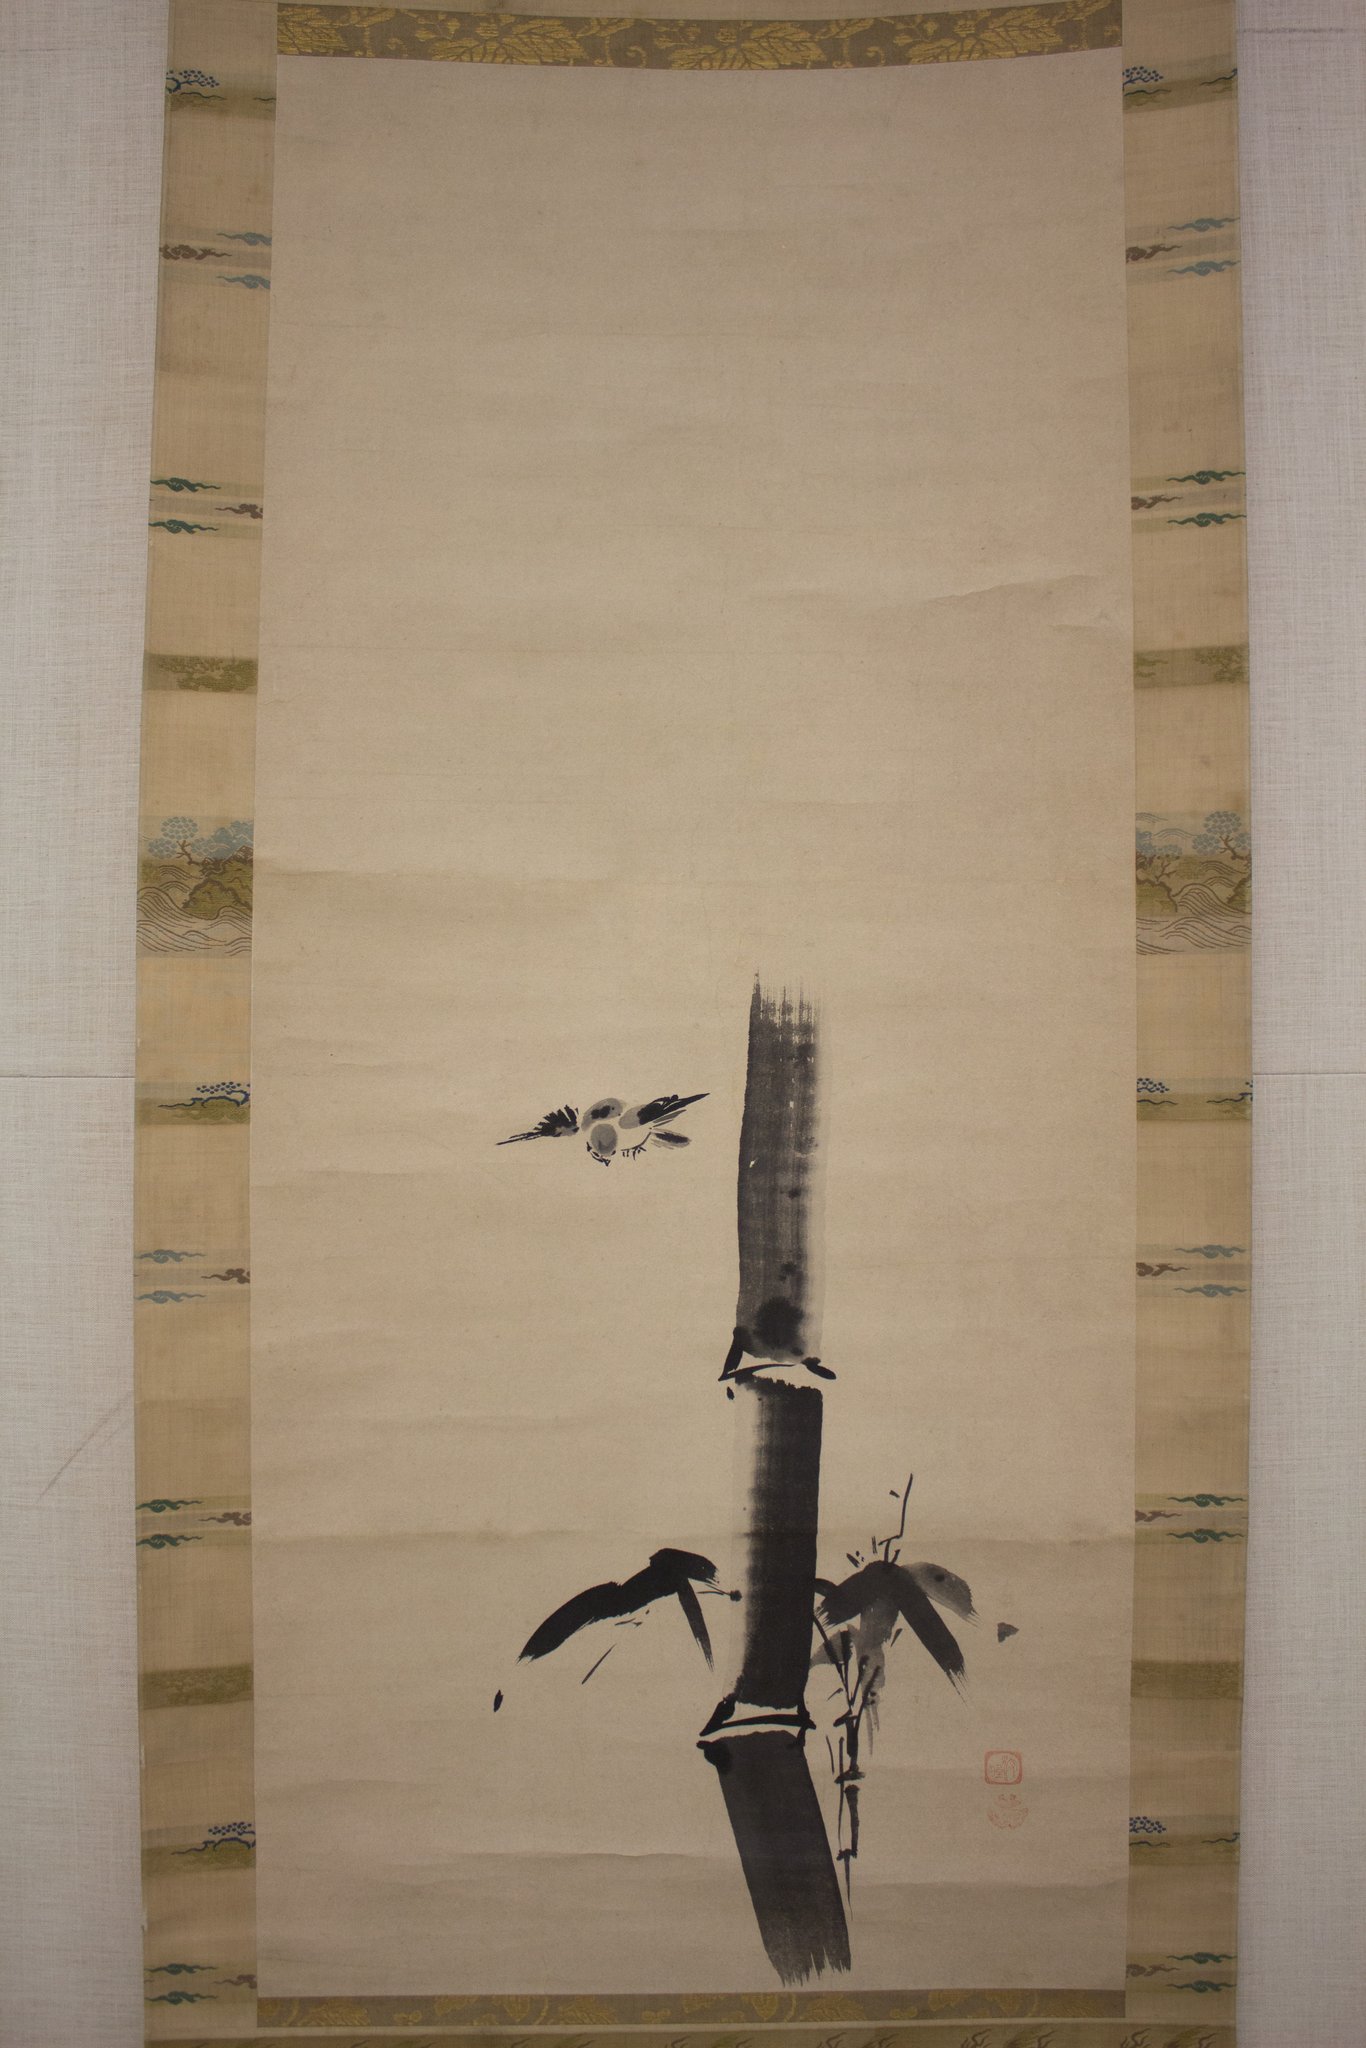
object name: hanging scroll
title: Sparrow and Bamboo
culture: japanese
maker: kano tan'yū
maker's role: artist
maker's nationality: japanese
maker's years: 1602-1674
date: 1601-1800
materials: ink, paper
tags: birds,bamboo